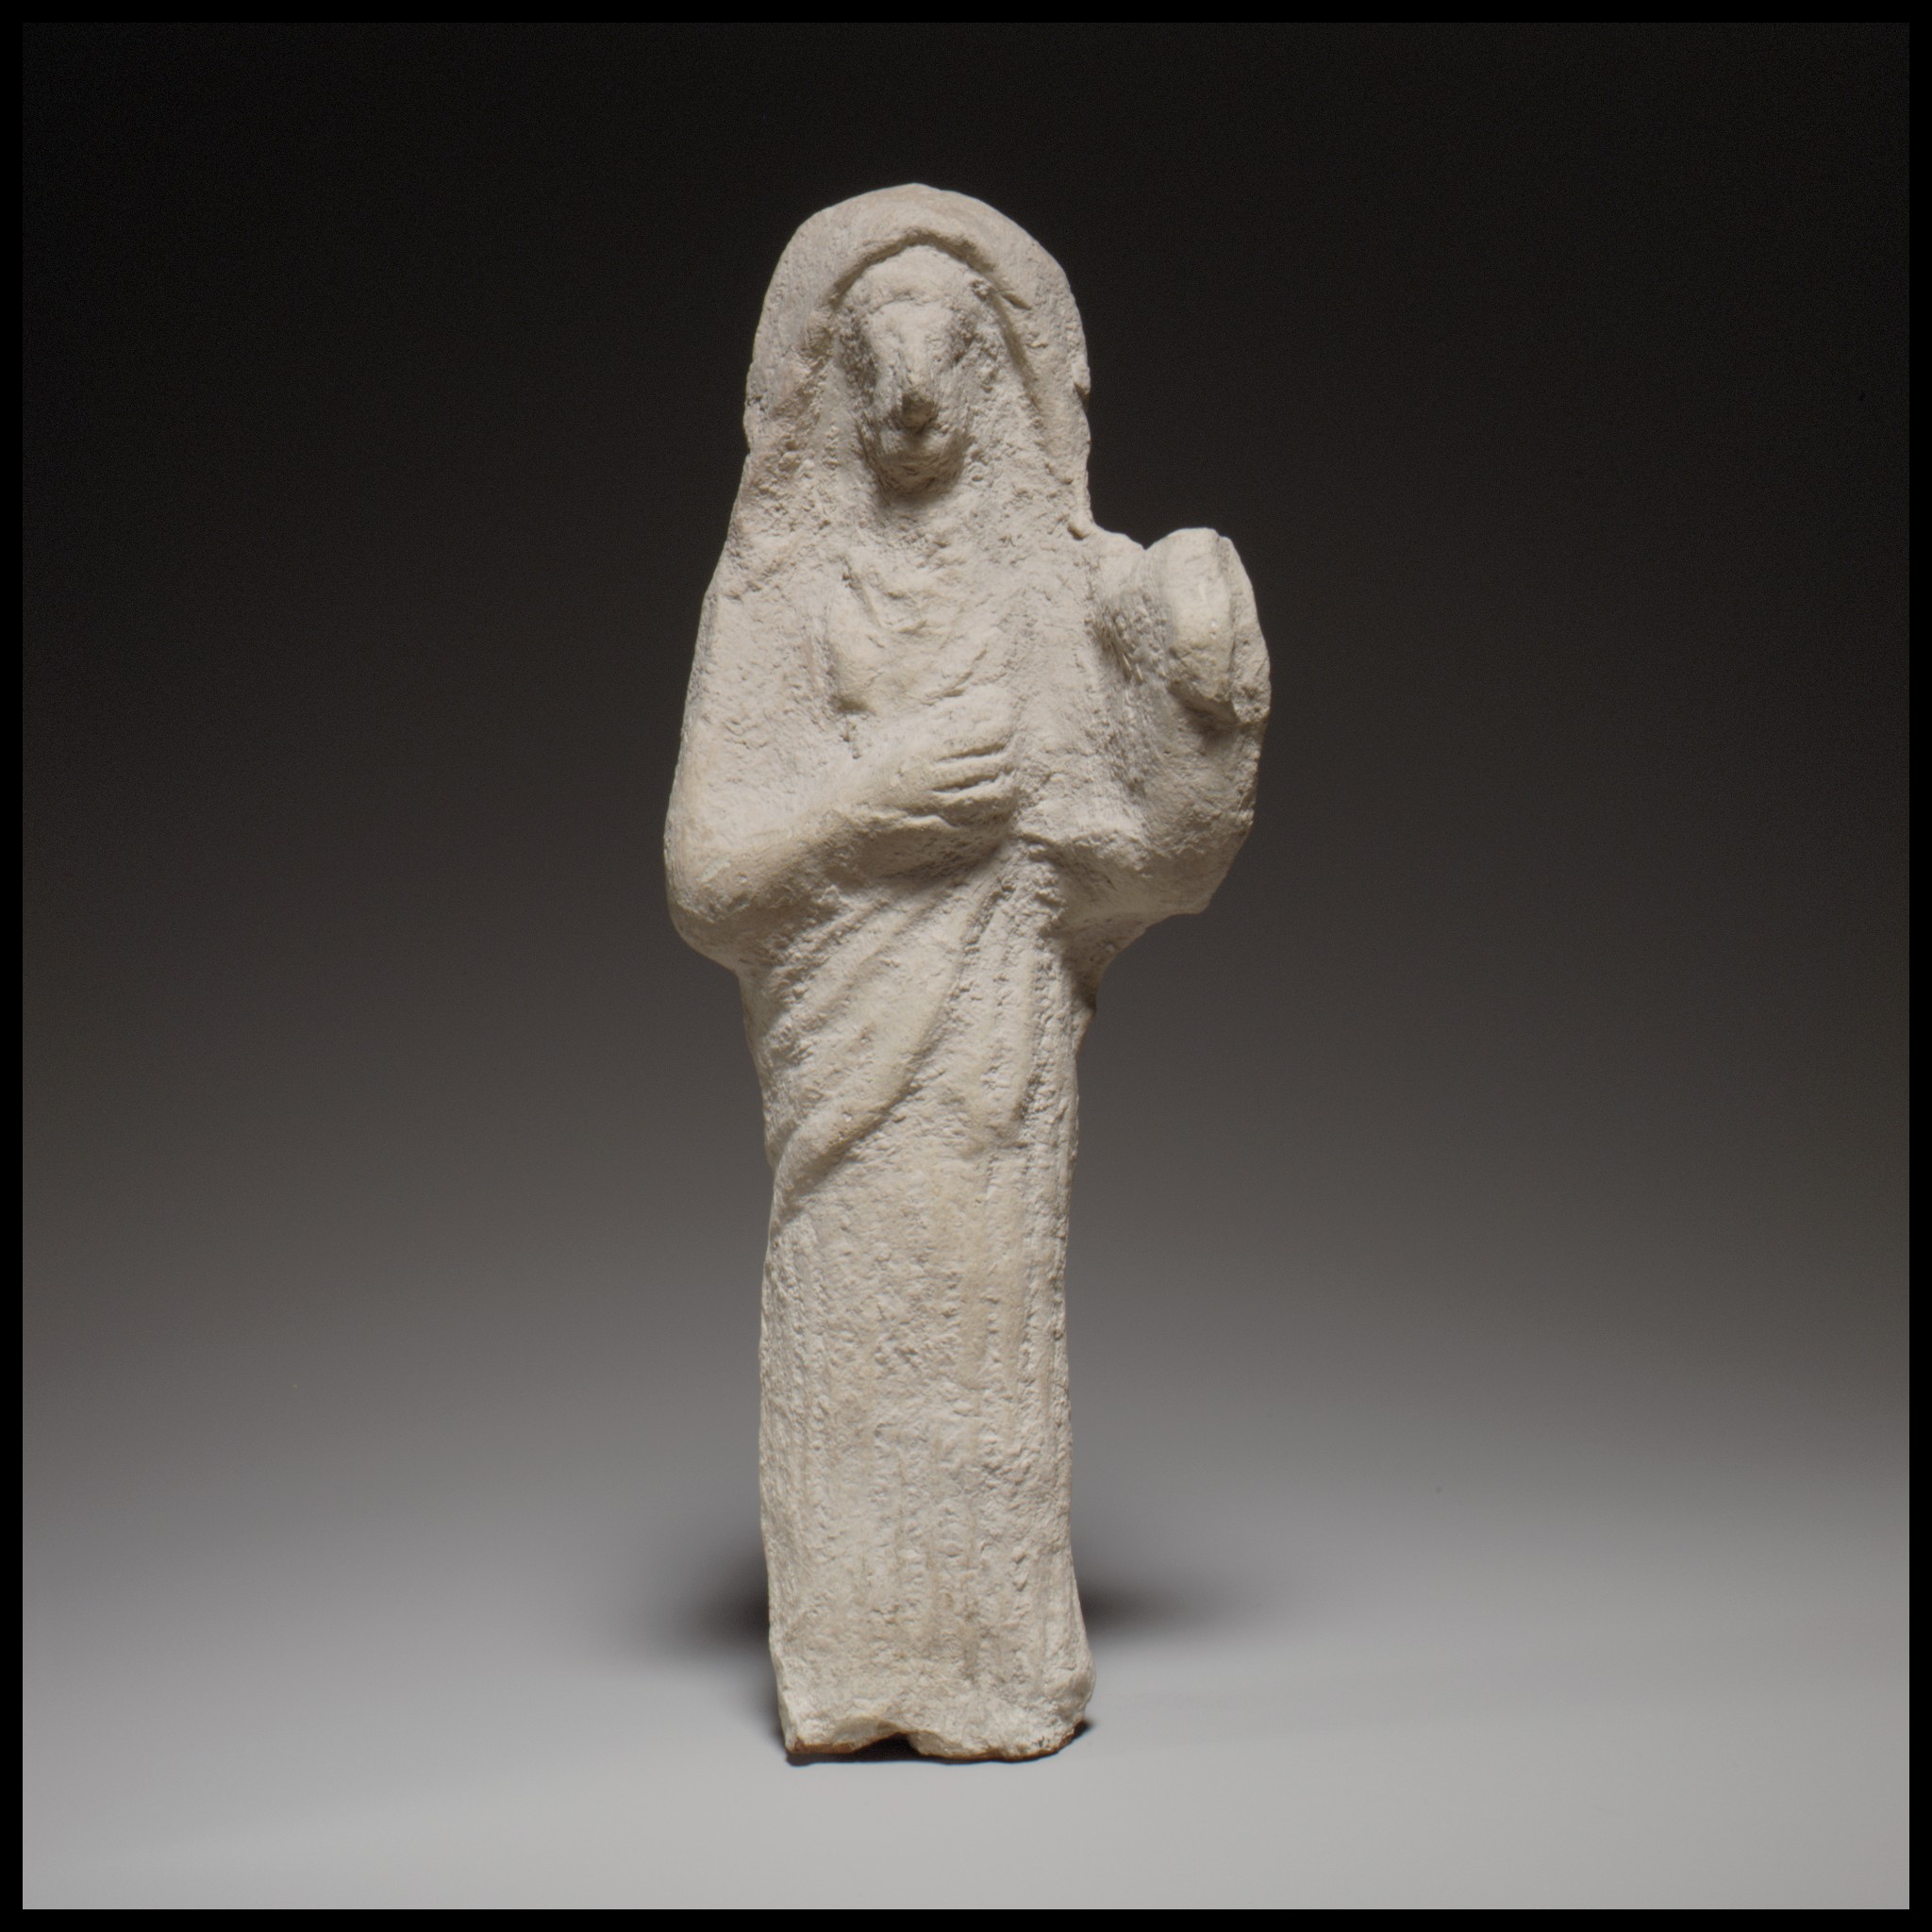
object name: statuette of a female with lyre from a ring dance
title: Standing female lyre player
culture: cypriot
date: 600-480 BCE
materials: terracotta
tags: women,musicians,lyres